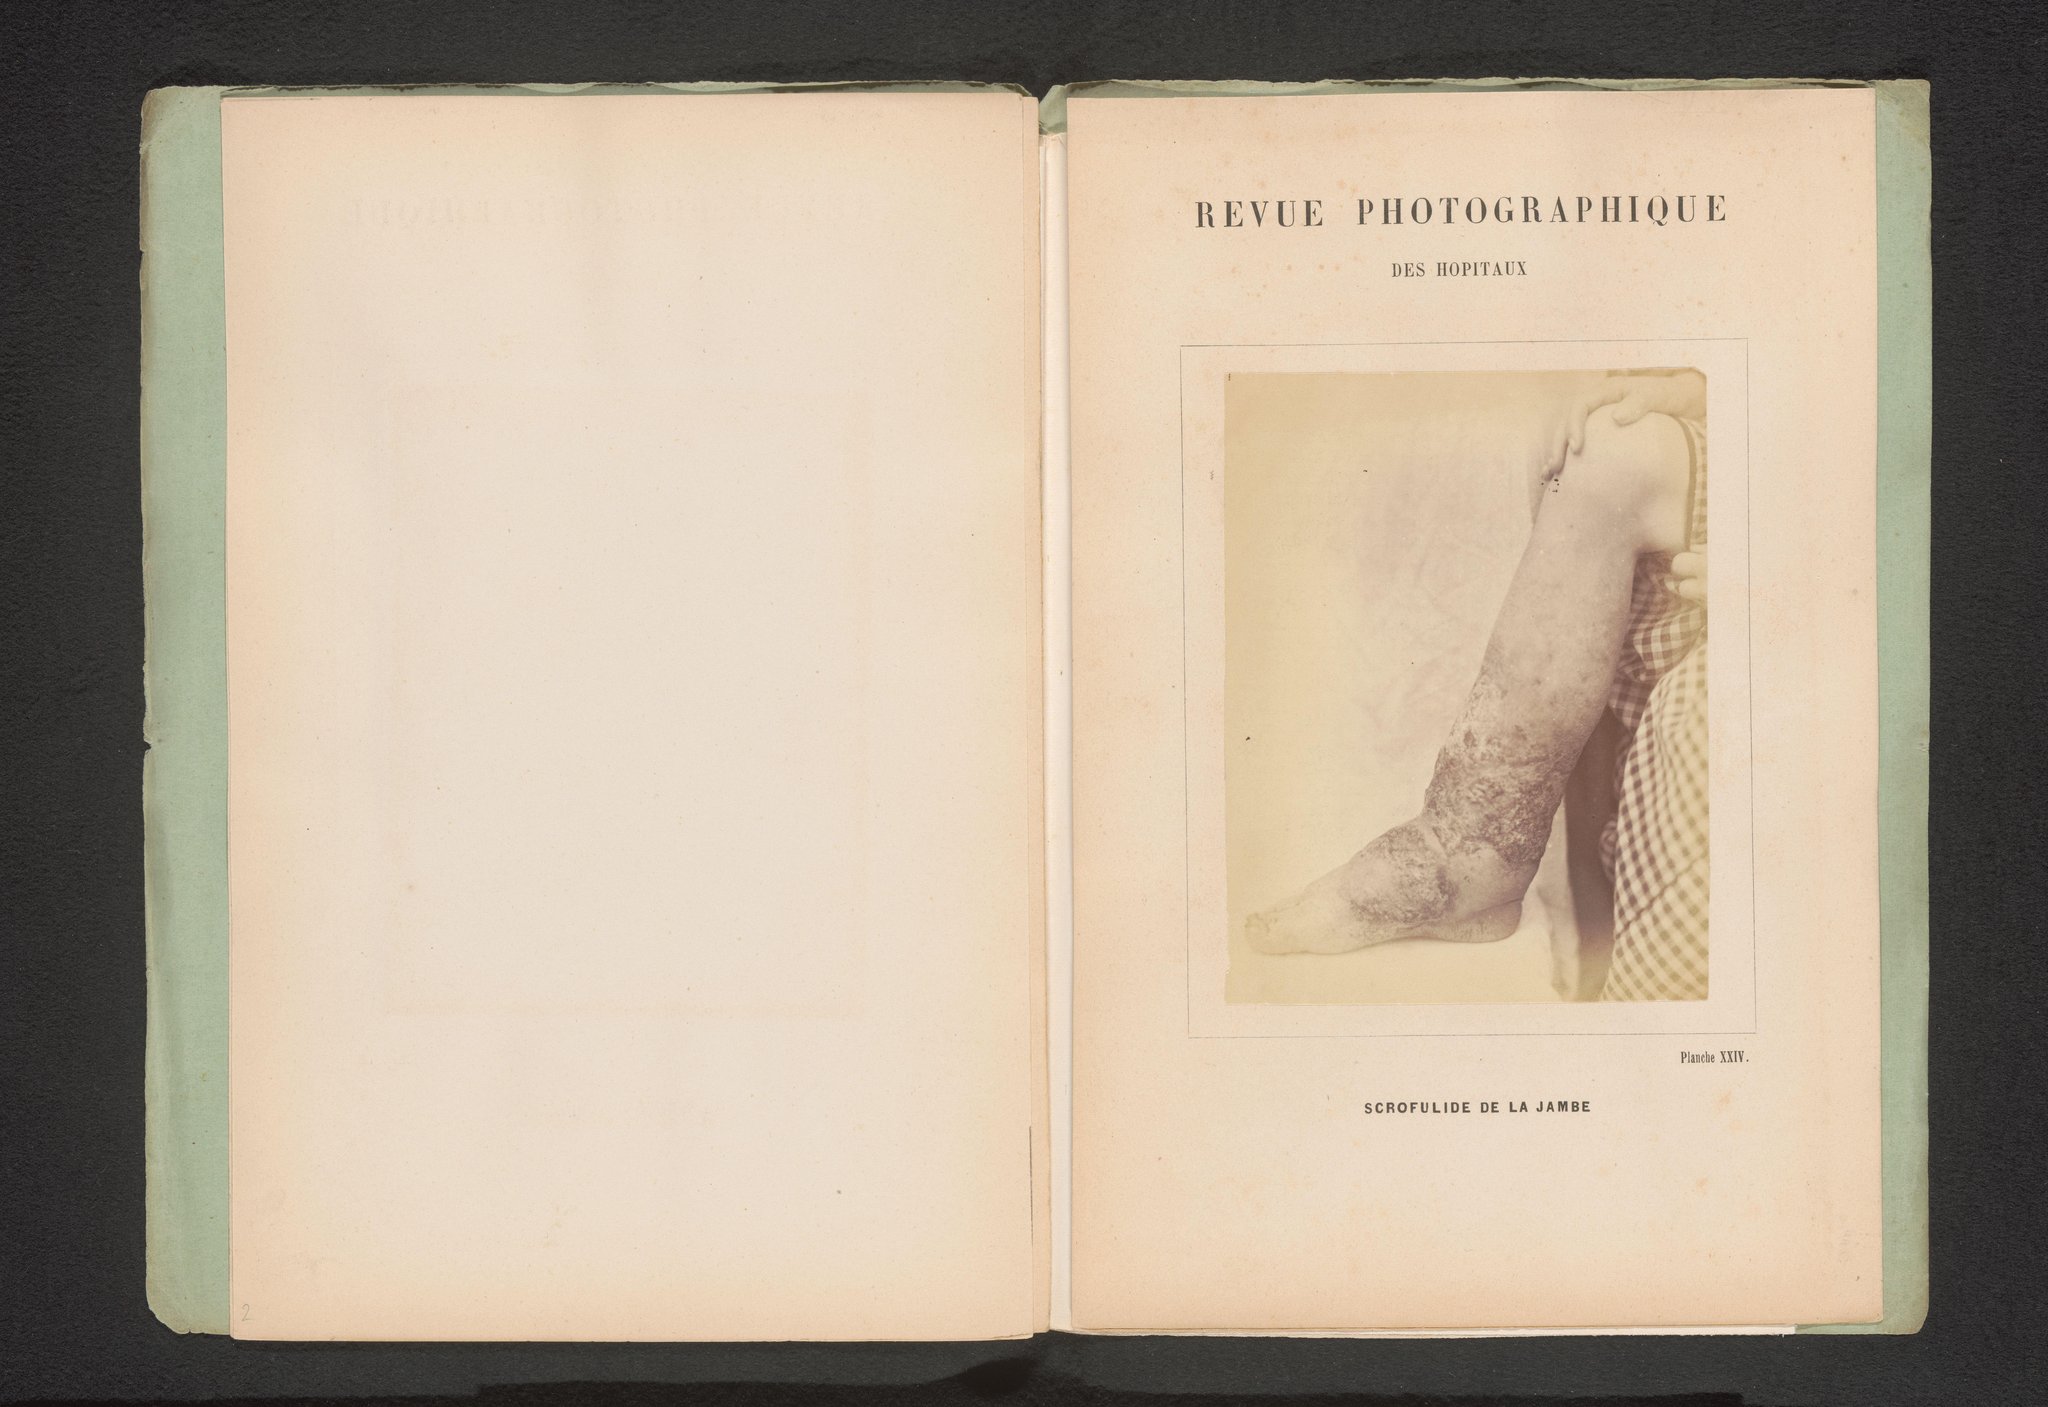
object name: page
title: Scrofulide de la jambe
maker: Anonymous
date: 1865-1870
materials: paper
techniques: albumen print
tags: lower leg, medical research, branches of medicine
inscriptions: inscription: ‘Revue photographique/ des hopitaux/ Planche XXIV.’